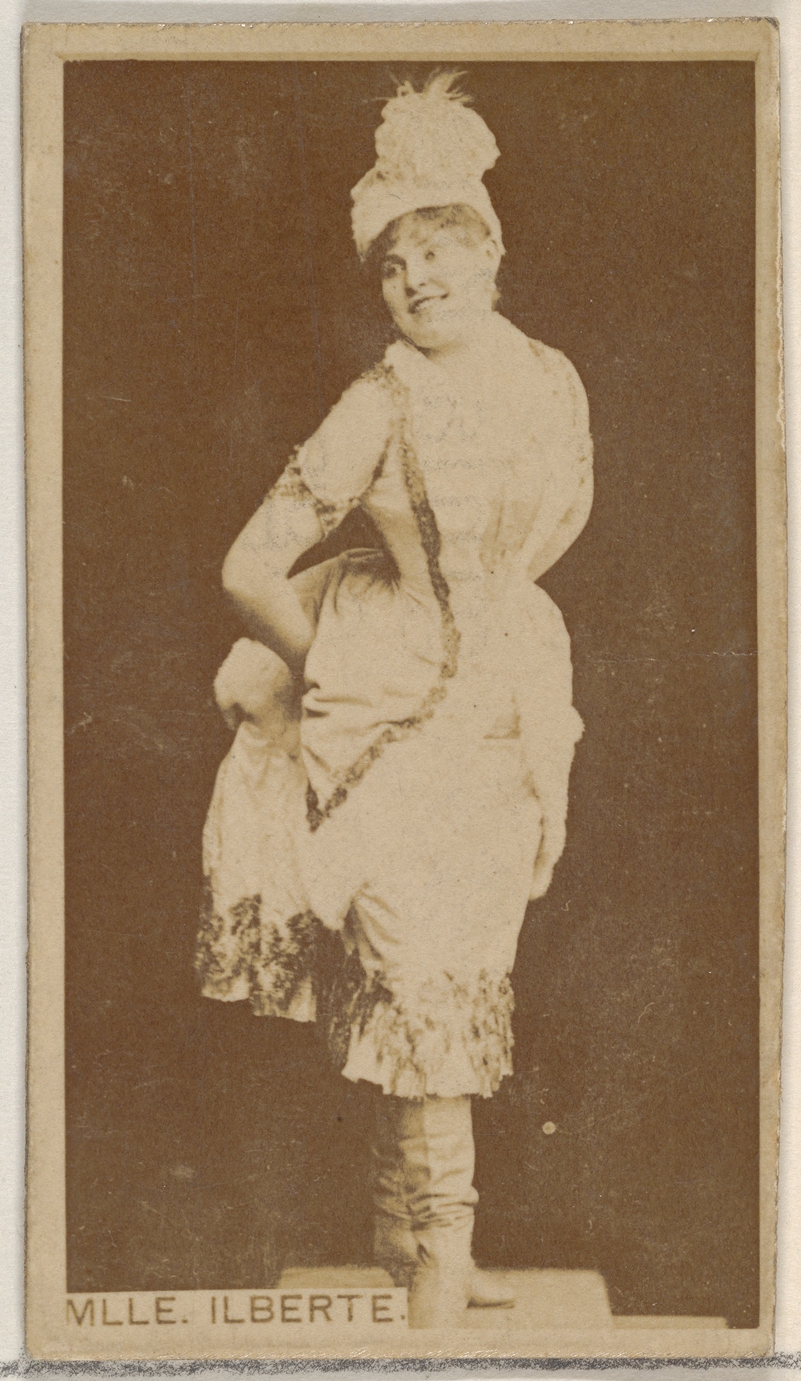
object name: photograph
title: Mlle. Ilberte, from the Actors and Actresses series (N45, Type 8) for Virginia Brights Cigarettes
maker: allen & ginter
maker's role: publisher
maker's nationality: american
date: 1888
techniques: albumen silver print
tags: portraits,women,actresses